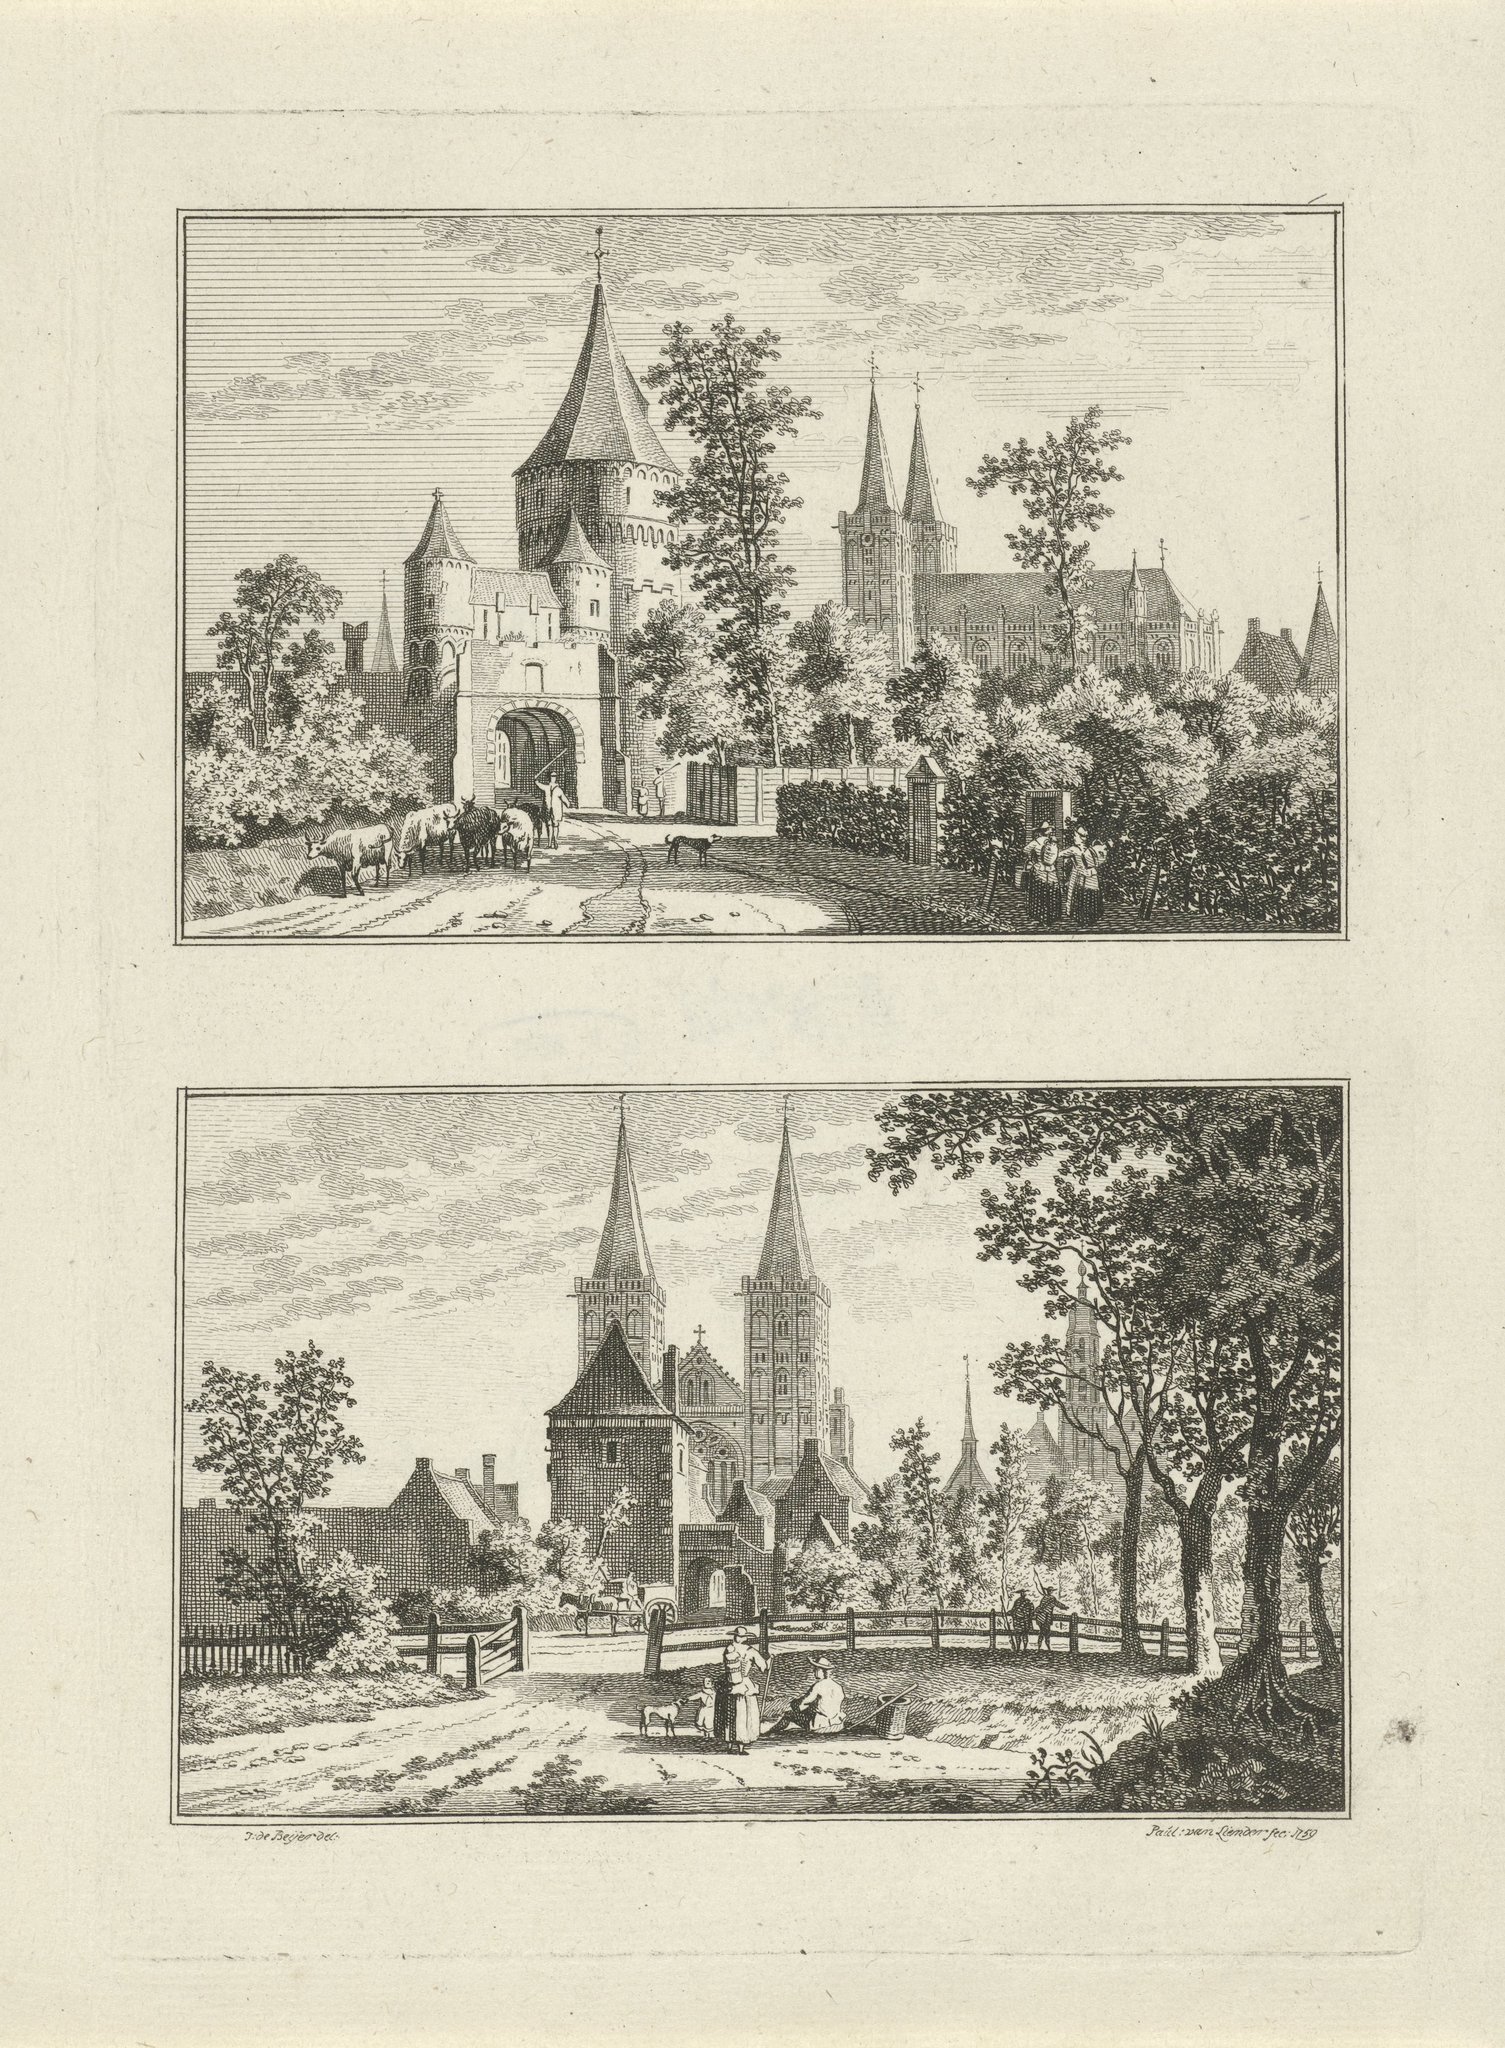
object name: print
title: Scharenpoort en Meerpoort te Xanten, 1746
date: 1759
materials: paper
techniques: etching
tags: city-gate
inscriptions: collector's mark: Lugt 2228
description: Twee voorstellingen van één plaat. Gezichten op de Scharenpoort (boven) en de Meerpoort (onder) in de Duitse stad Xanten. De prent maakt deel uit van een 100-delige serie met gezichten op dorpen en steden te Kleef.